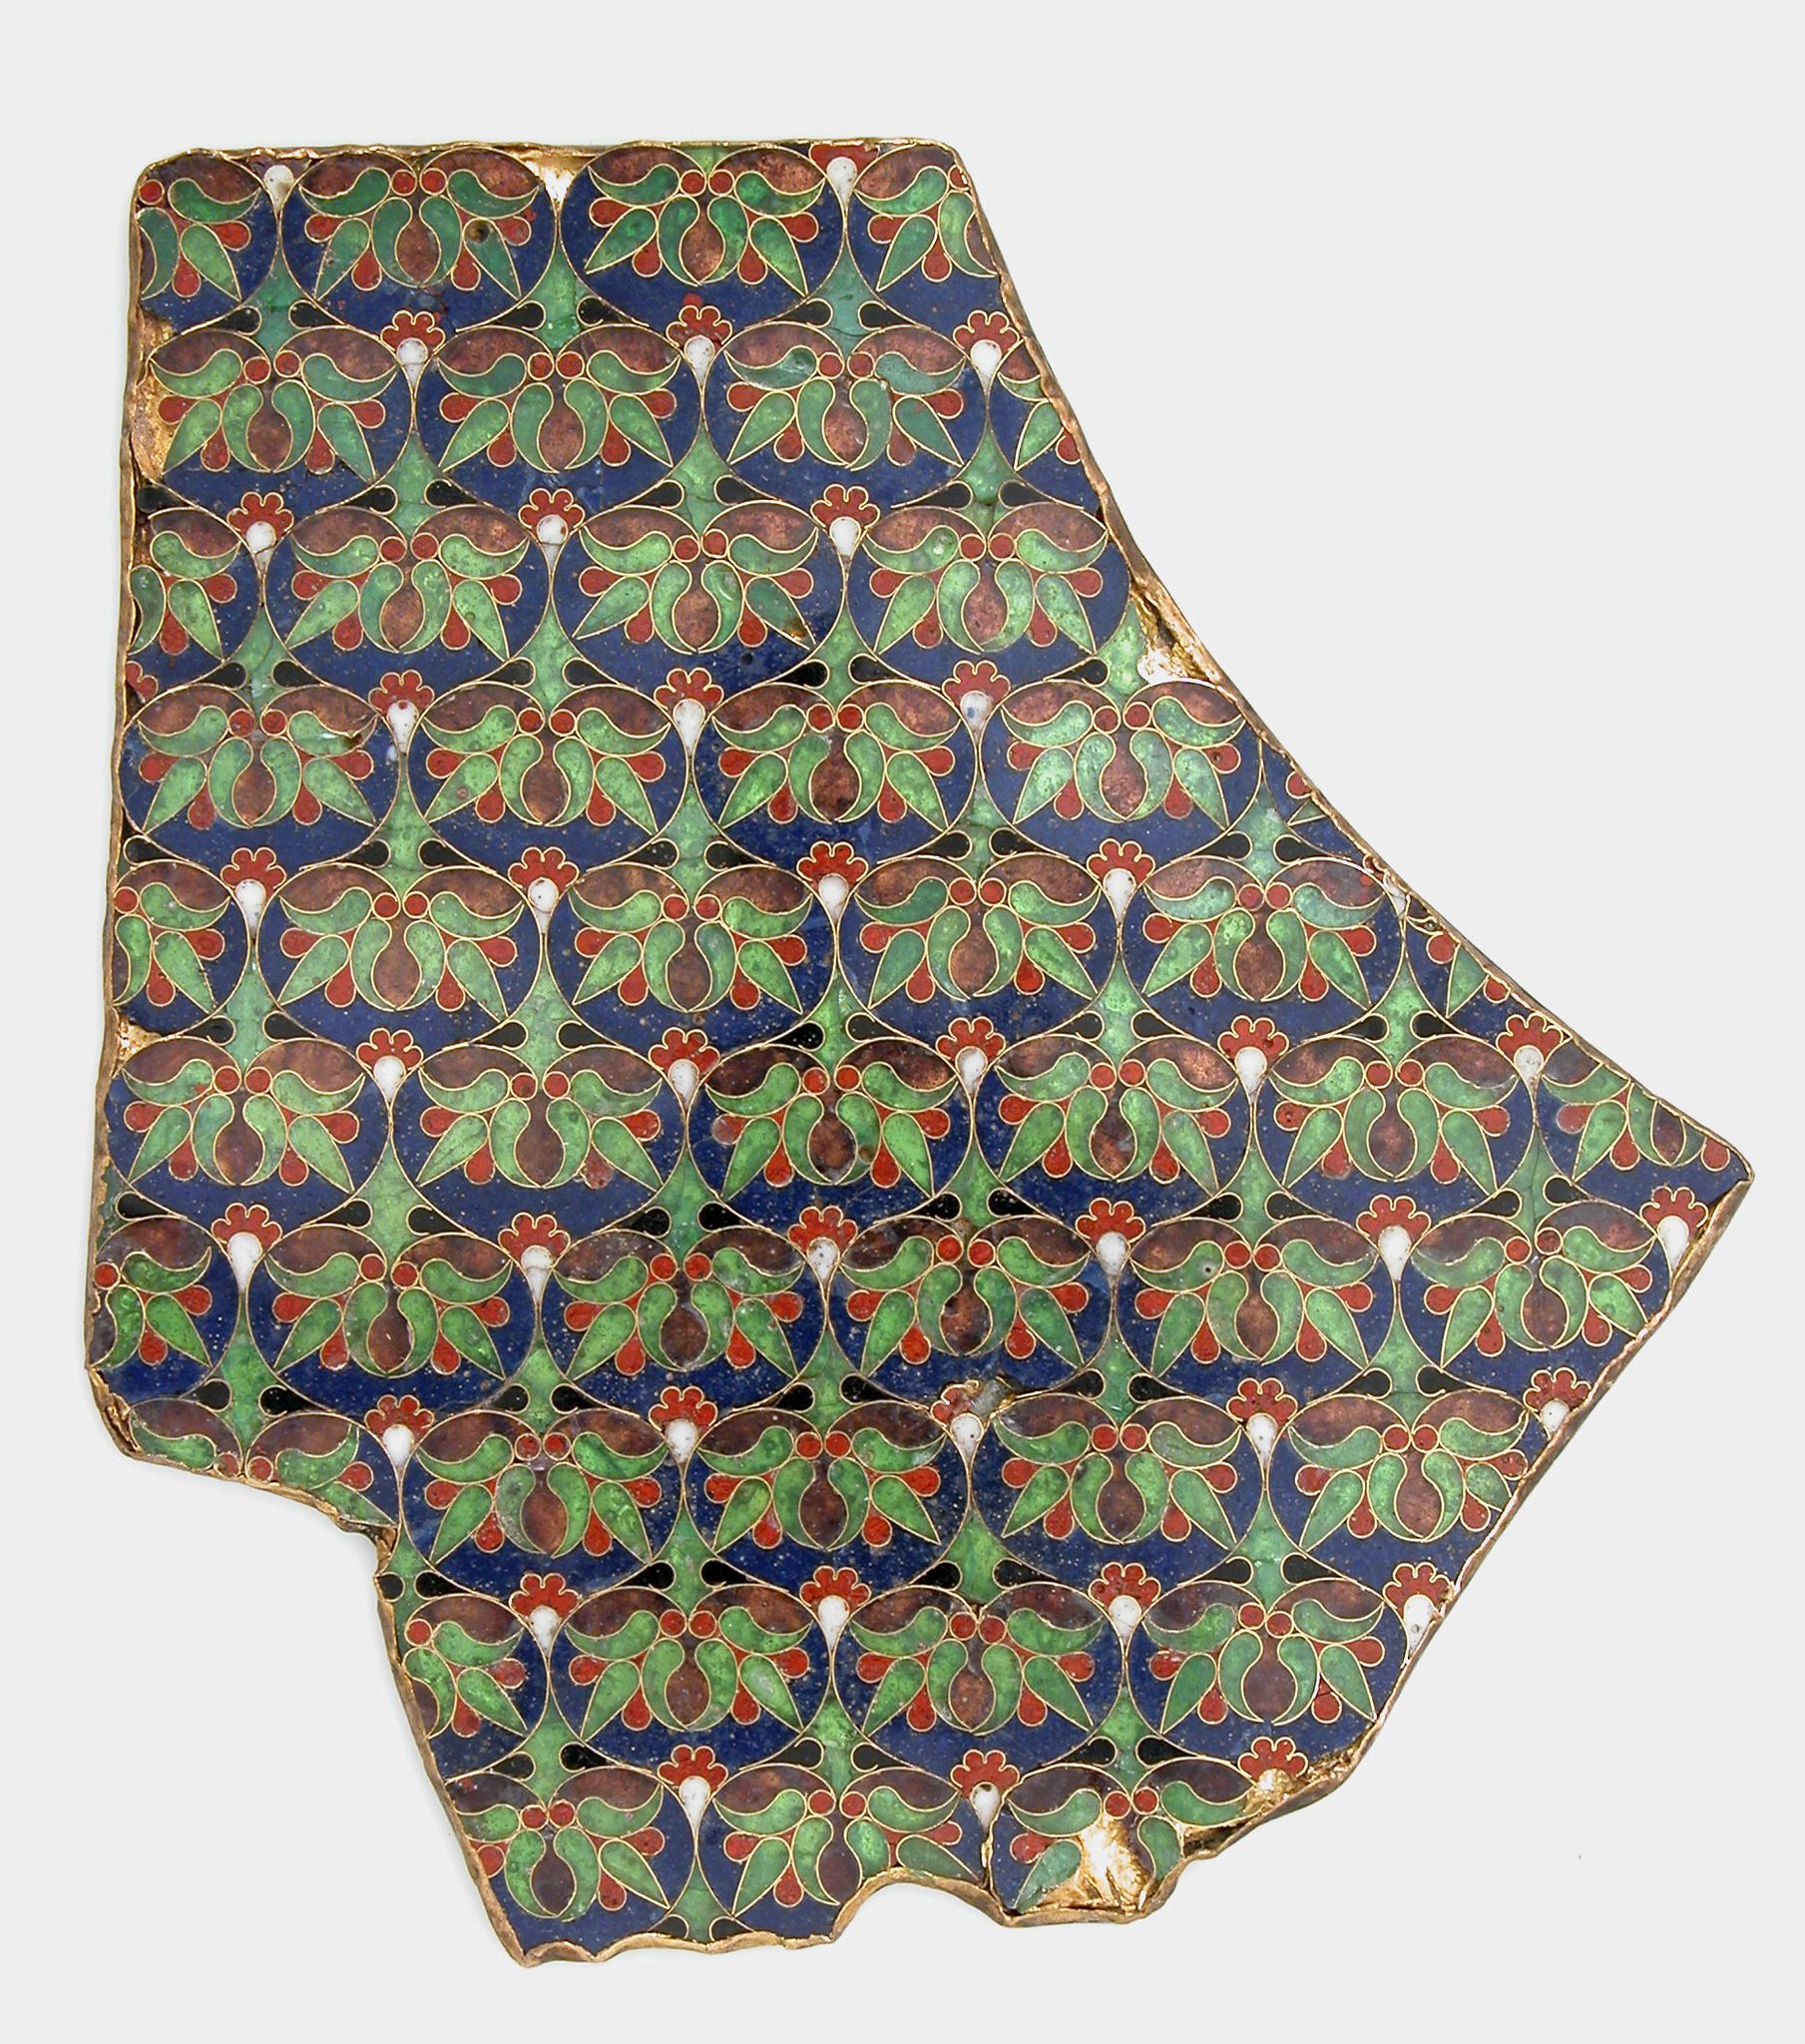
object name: enamel fragment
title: Panel from a Cover for an Icon of the Virgin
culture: byzantine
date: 1100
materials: copper, enamel, gold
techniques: enamel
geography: constantinople